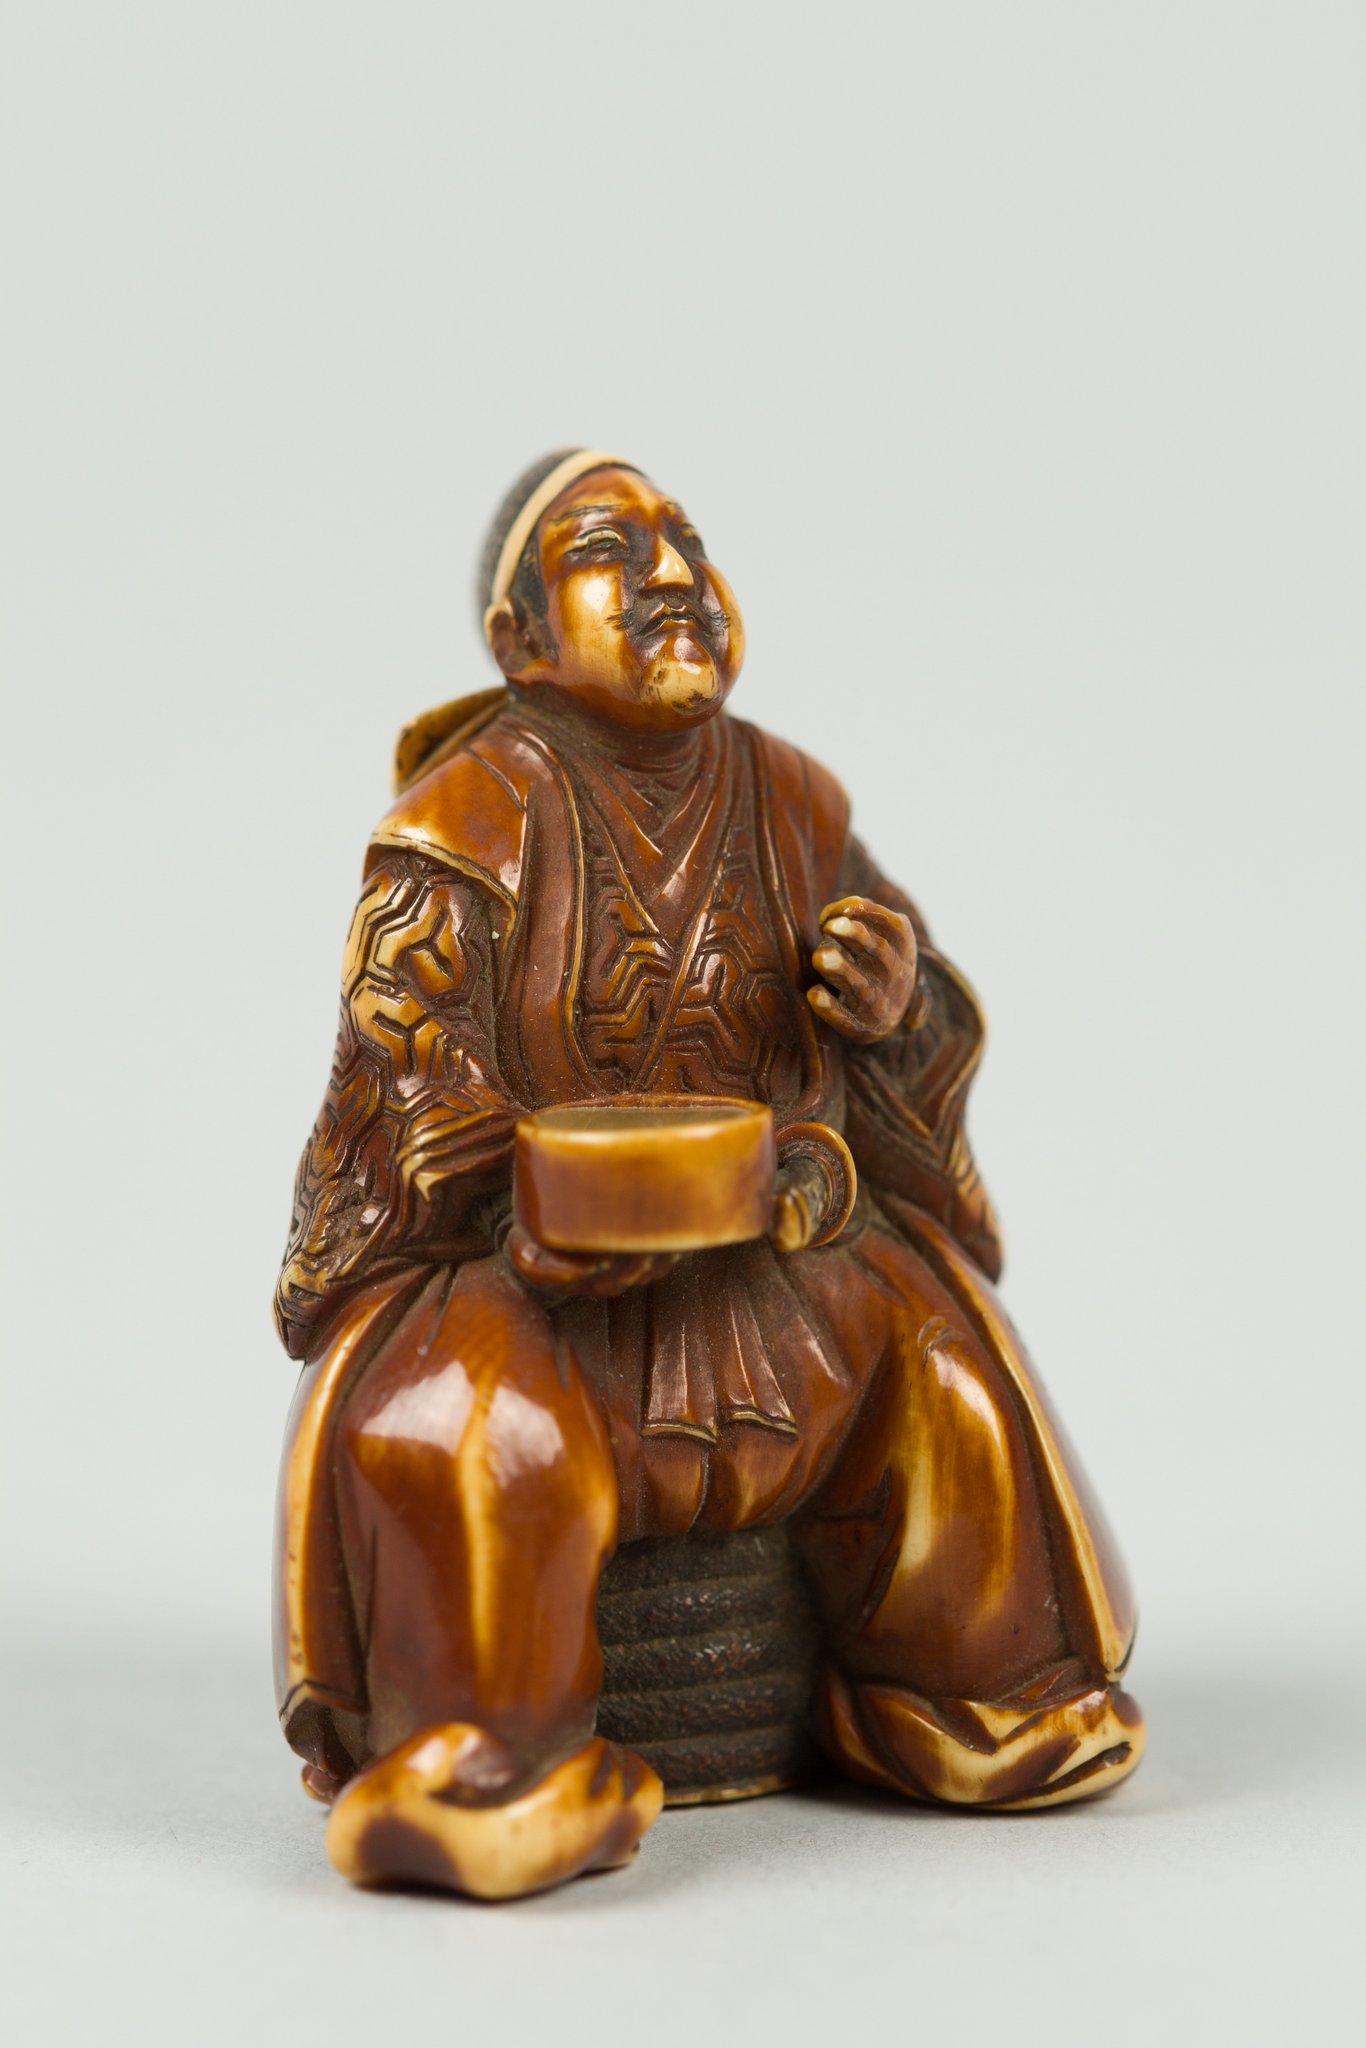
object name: netsuke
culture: japanese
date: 1801-1900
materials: ivory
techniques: stain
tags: men